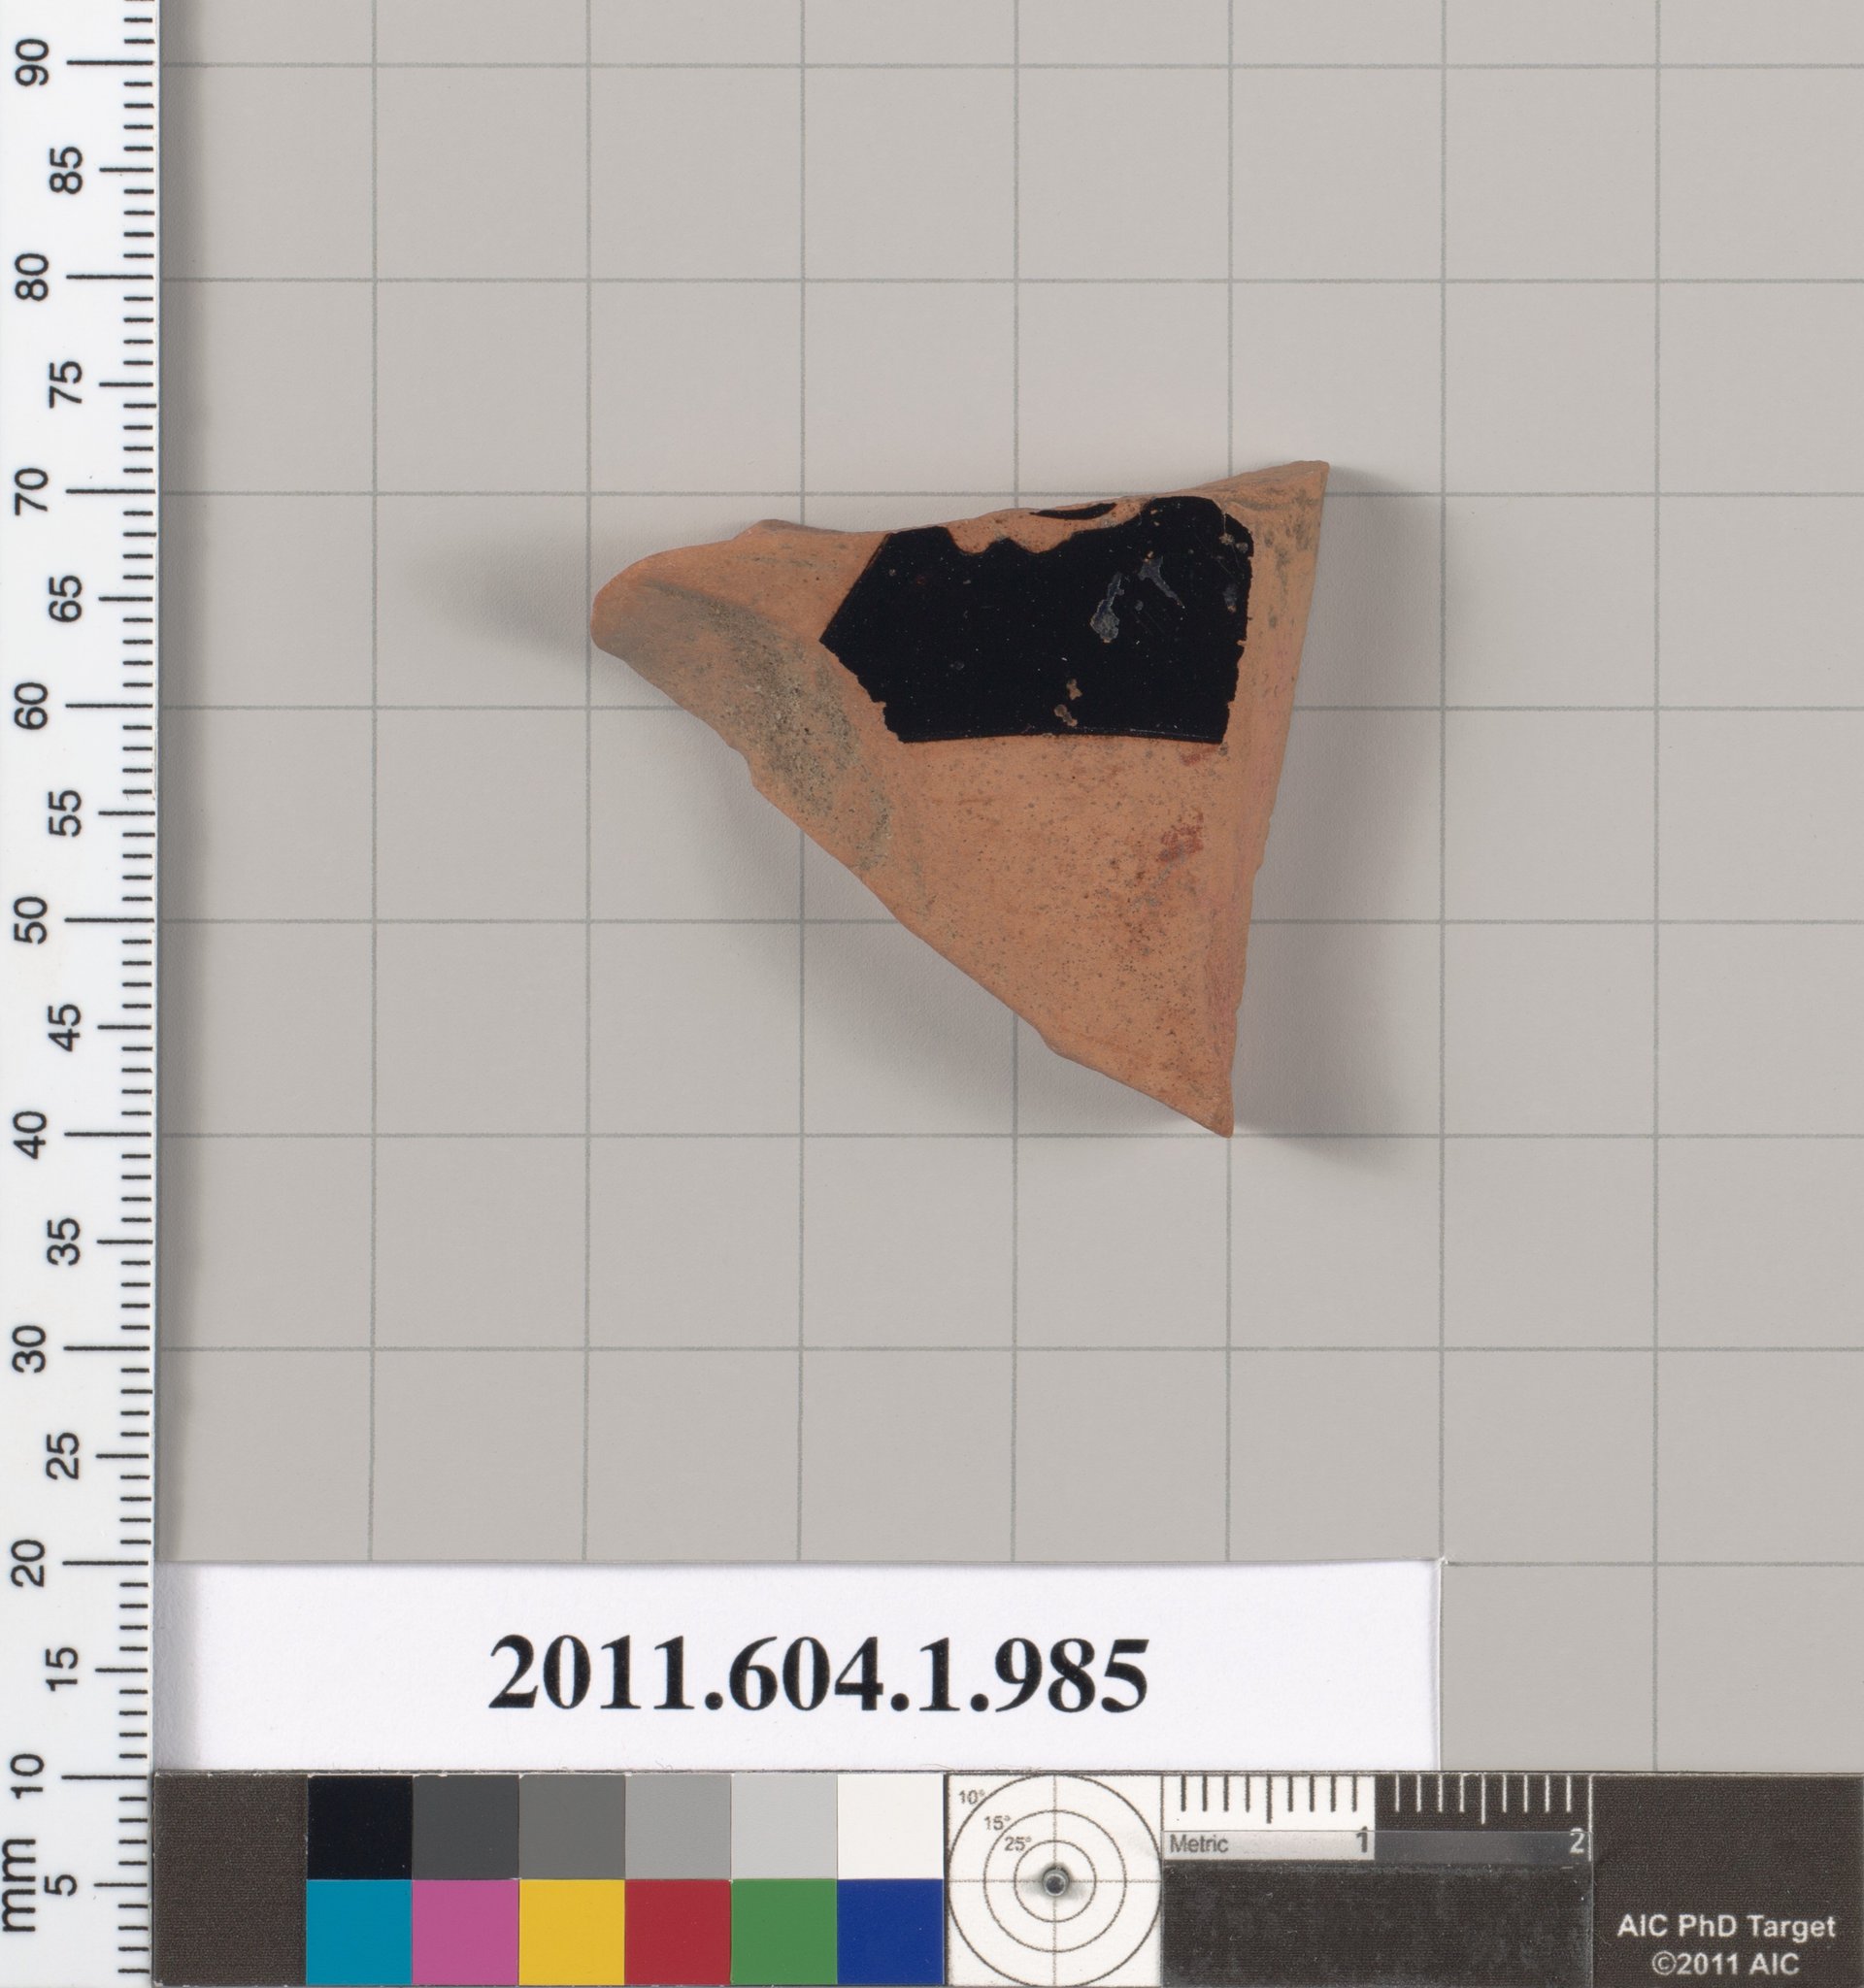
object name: kylix fragment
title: Terracotta fragment of a kylix (drinking cup)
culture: greek, attic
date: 490-480 BCE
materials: terracotta